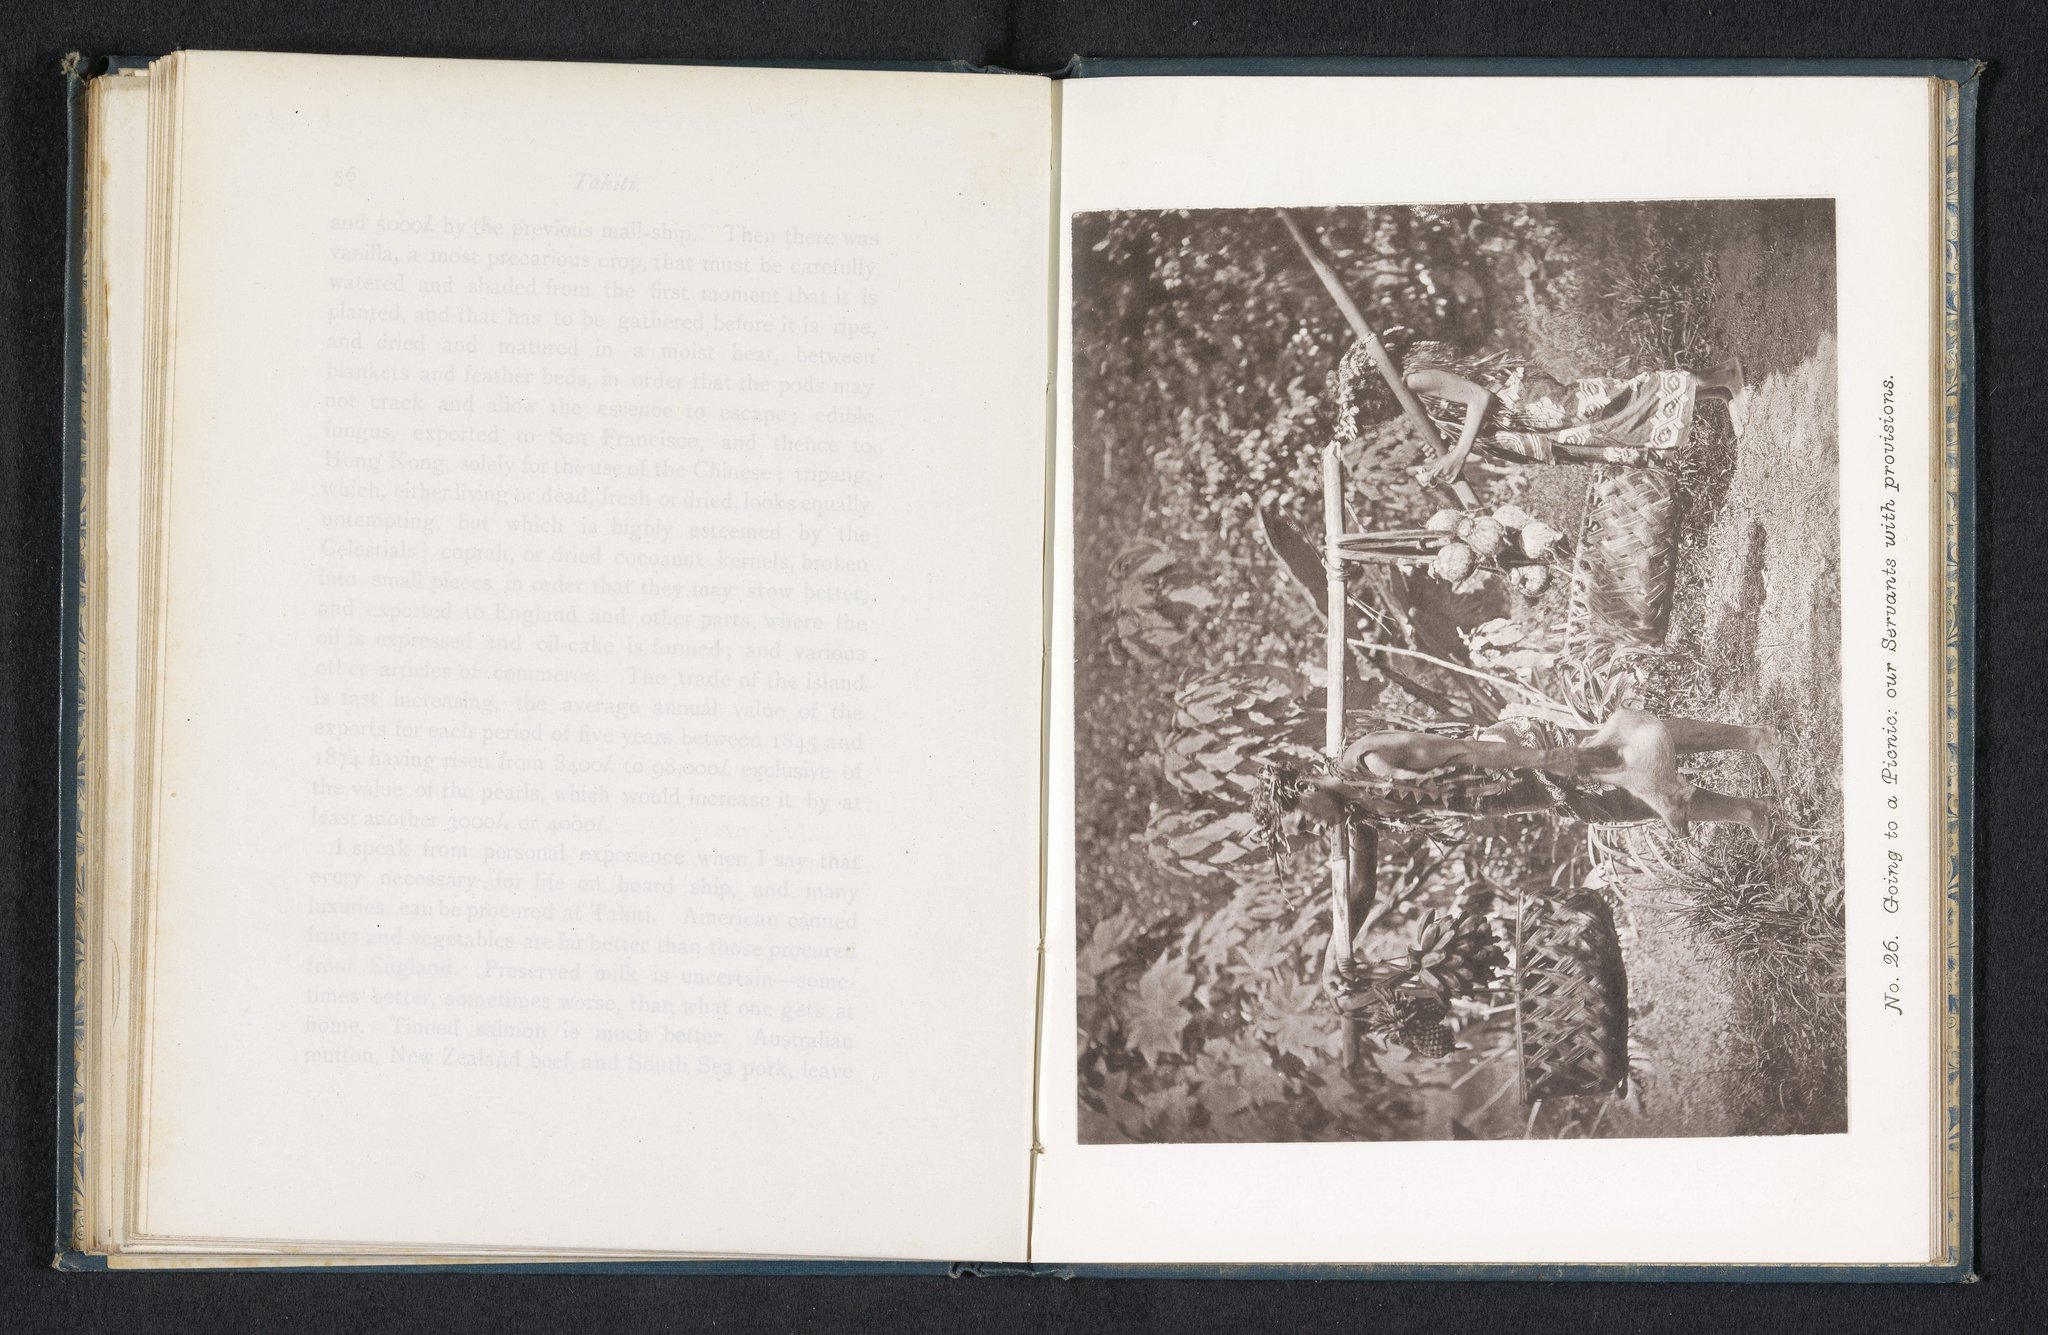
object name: photomechanical print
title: Man en vrouw met eten voor een picknick in Tahiti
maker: henry stuart-wortley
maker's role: fotograaf, kolonel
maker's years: 1832-1890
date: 1880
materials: paper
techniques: photograph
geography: tahiti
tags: picnic, alfresco, 'déjeuner sur l'herbe'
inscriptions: number: ‘No. 26.’